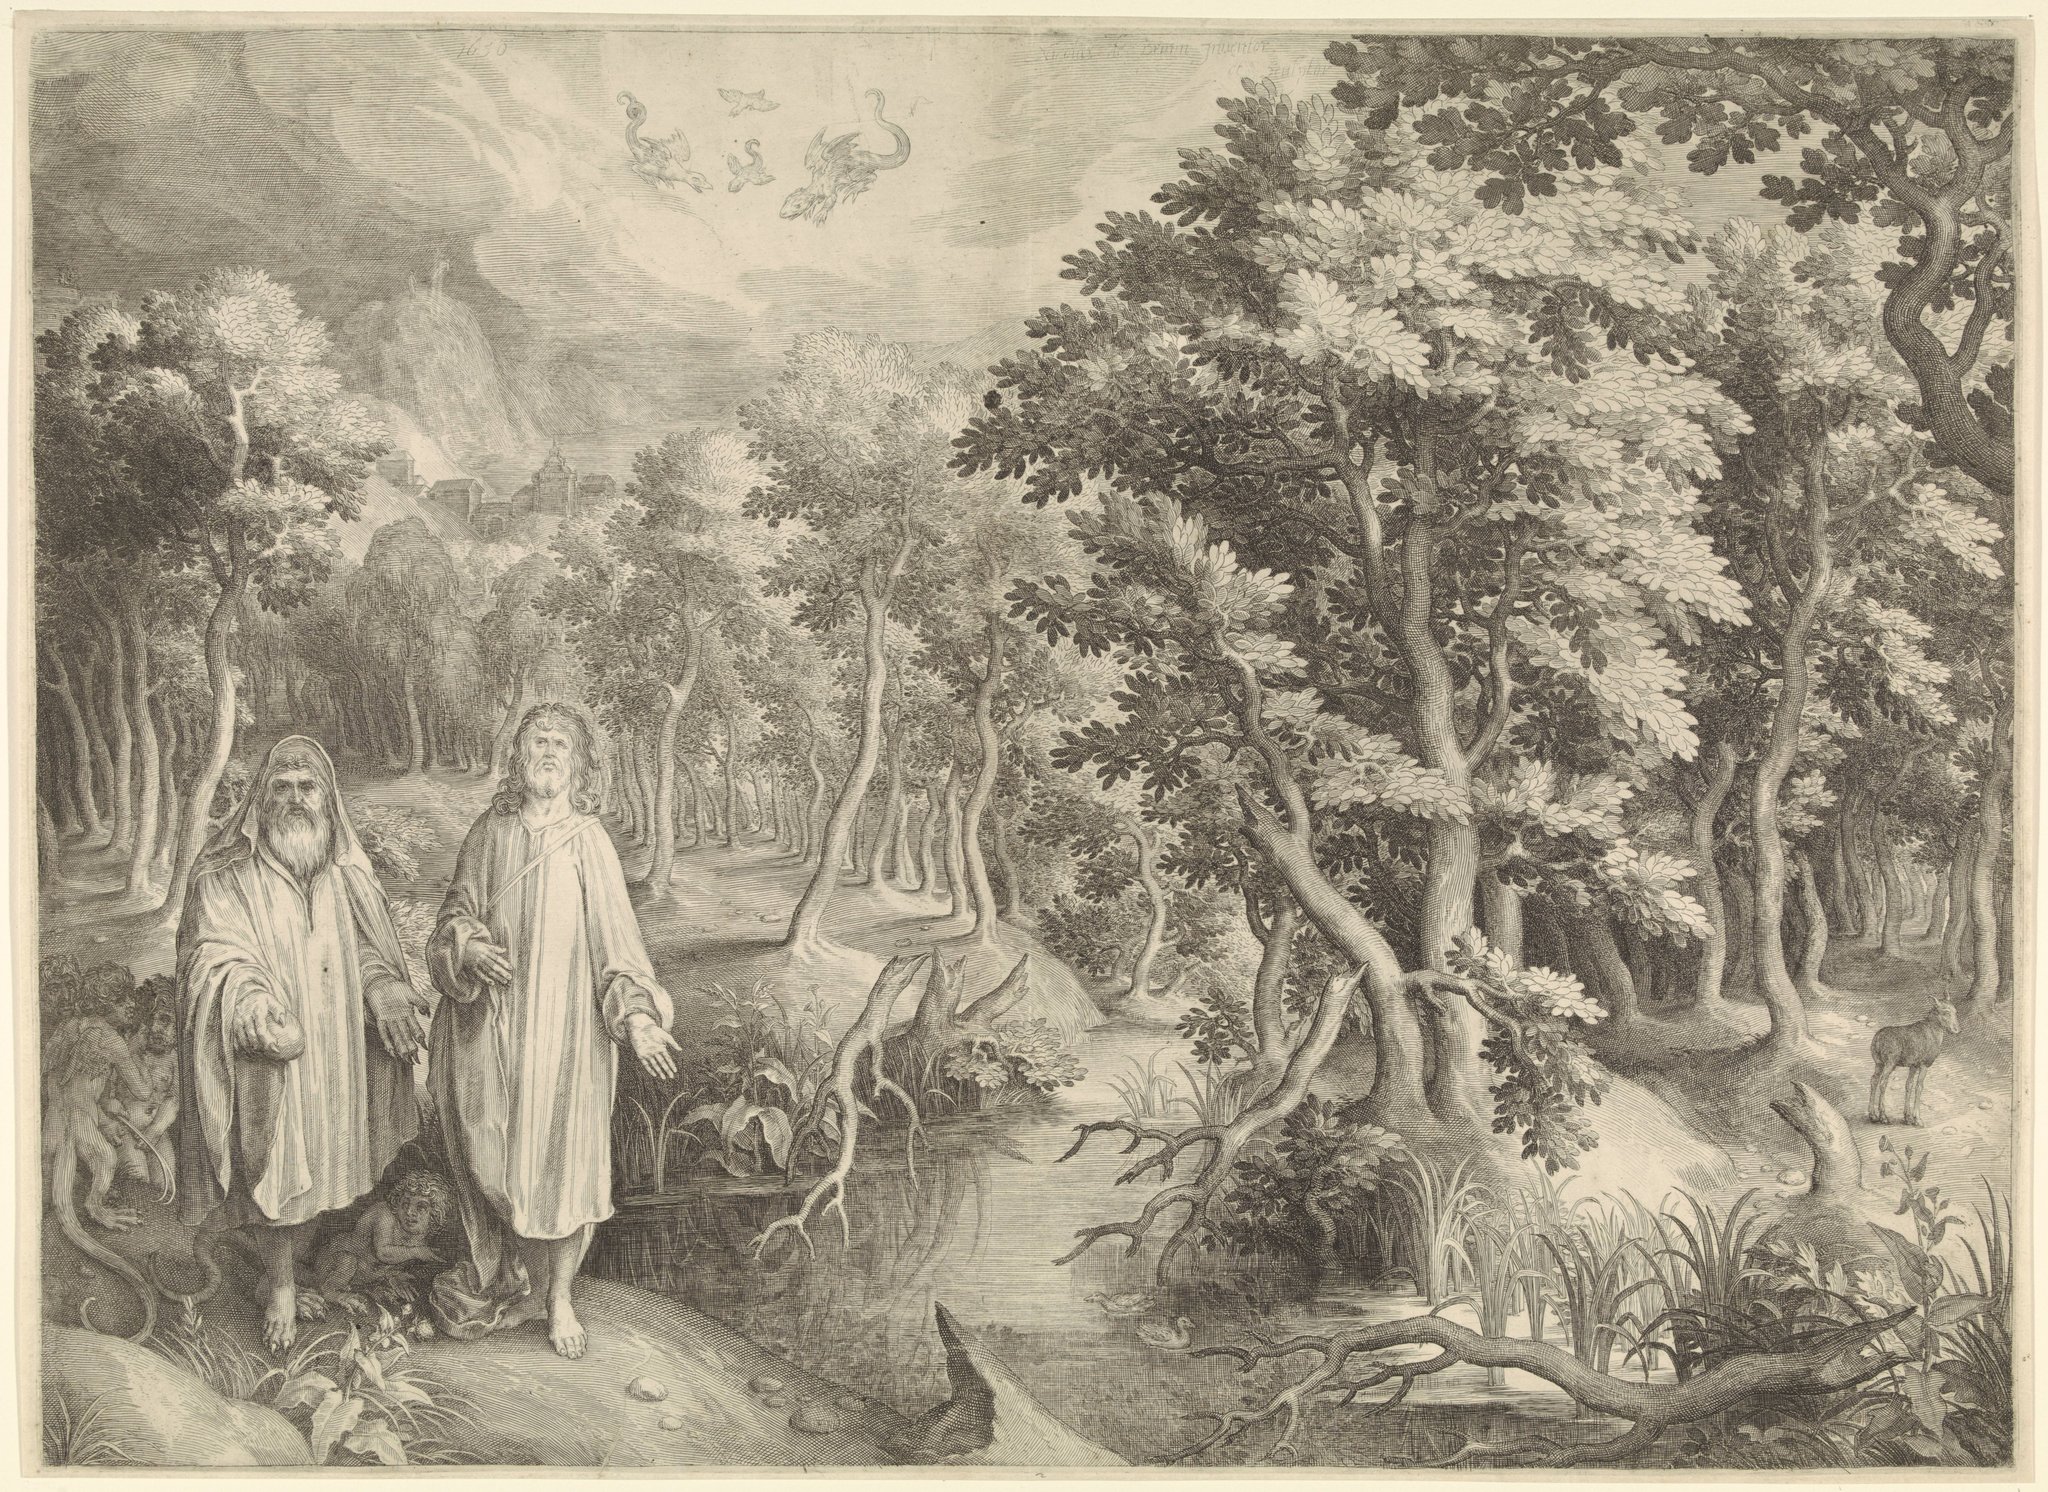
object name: print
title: Verzoeking van Christus in de woestijn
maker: nicolaes de bruyn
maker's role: print maker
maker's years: 1571-1656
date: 1650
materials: paper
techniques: engraving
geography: rotterdam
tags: 'command these stones to become loaves of bread' ~ temptation of christ in the wilderness, 'all these will i give you' (= the glory of the world) ~ temptation of christ in the wilderness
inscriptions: collector's mark: Lugt 2228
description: Een duivel toont Christus een steen en vraagt hem de steen in brood te veranderen als teken van zijn goddelijkheid (Matteüs 4:1-11). Rond de duivel allerlei kleine demonen. In de lucht vliegen draken. Op een achterliggende bergtop toont de duivel Christus alle koninkrijken van de wereld om hem te verleiden.